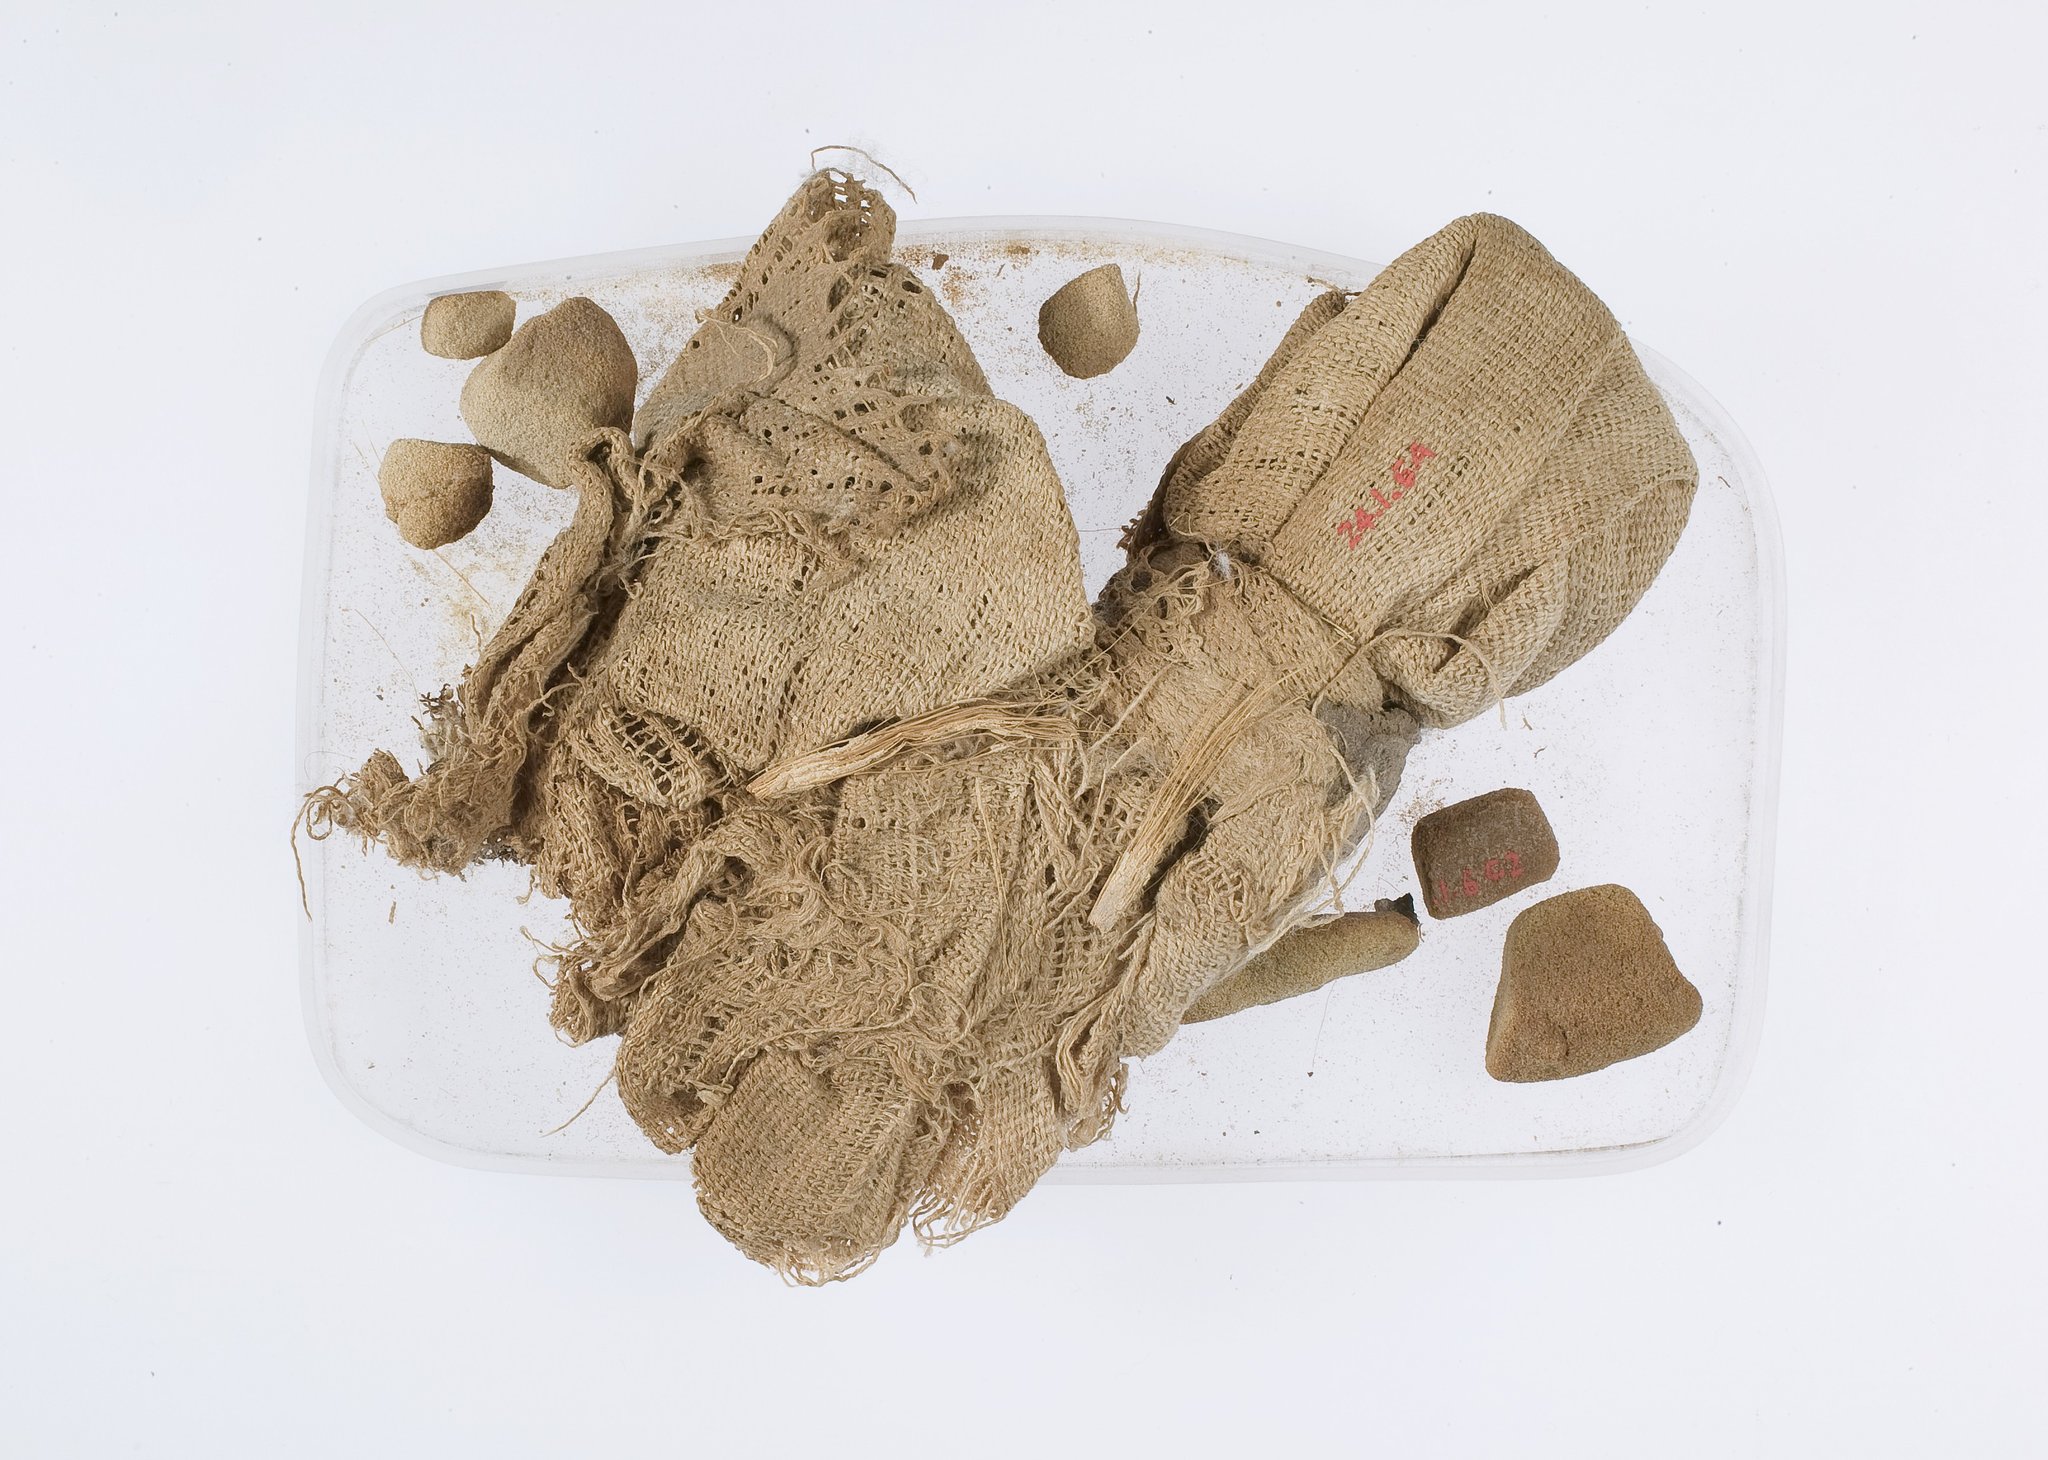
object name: whetstone 4, in bag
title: Cloth bag with hones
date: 1981-1640 BCE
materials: linen, stone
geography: egypt